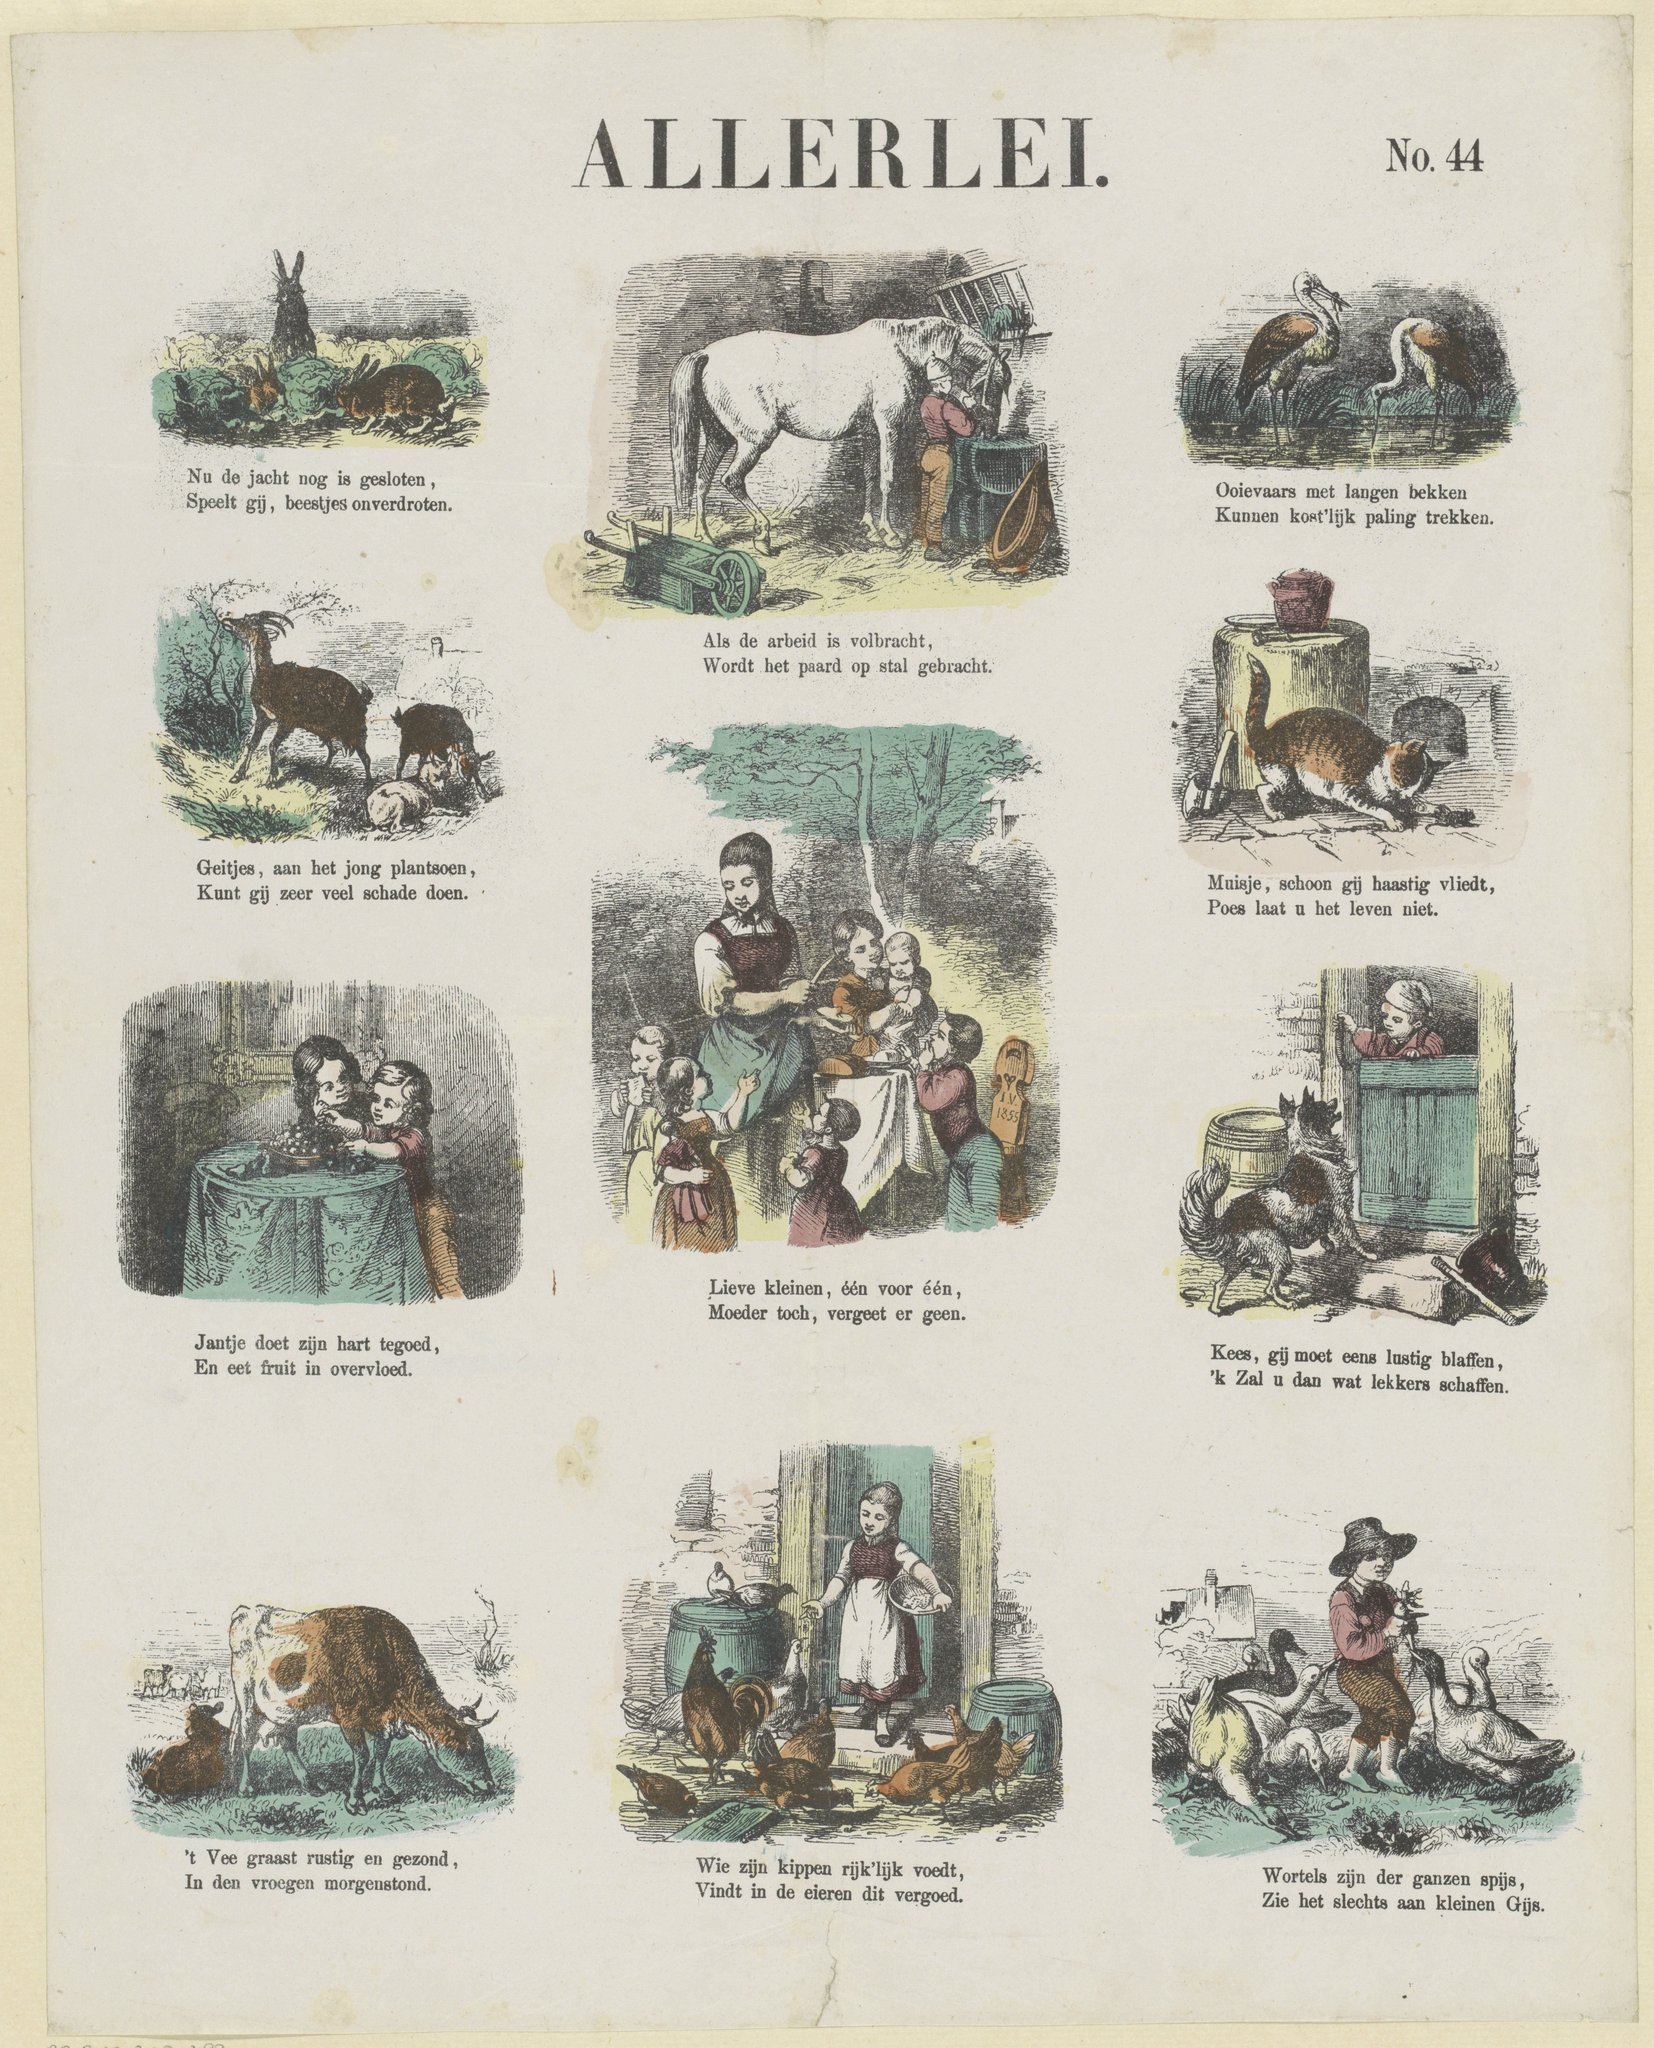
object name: popular print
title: Allerlei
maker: ludwig gustav voltz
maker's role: draughtsman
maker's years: 1825-1911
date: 1874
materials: paper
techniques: colour, letterpress printing, lithograph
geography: amsterdam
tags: animals, child, child playing with animals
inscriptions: collector's mark: Lugt 2760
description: Blad met 11 voorstellingen van verschillende aard, waaronder voorstellingen van dieren, kinderen die fruit eten en Kees die een hond iets lekkers geeft. Onder elke afbeelding een tweeregelig vers. Genummerd rechtsboven: No. 44.